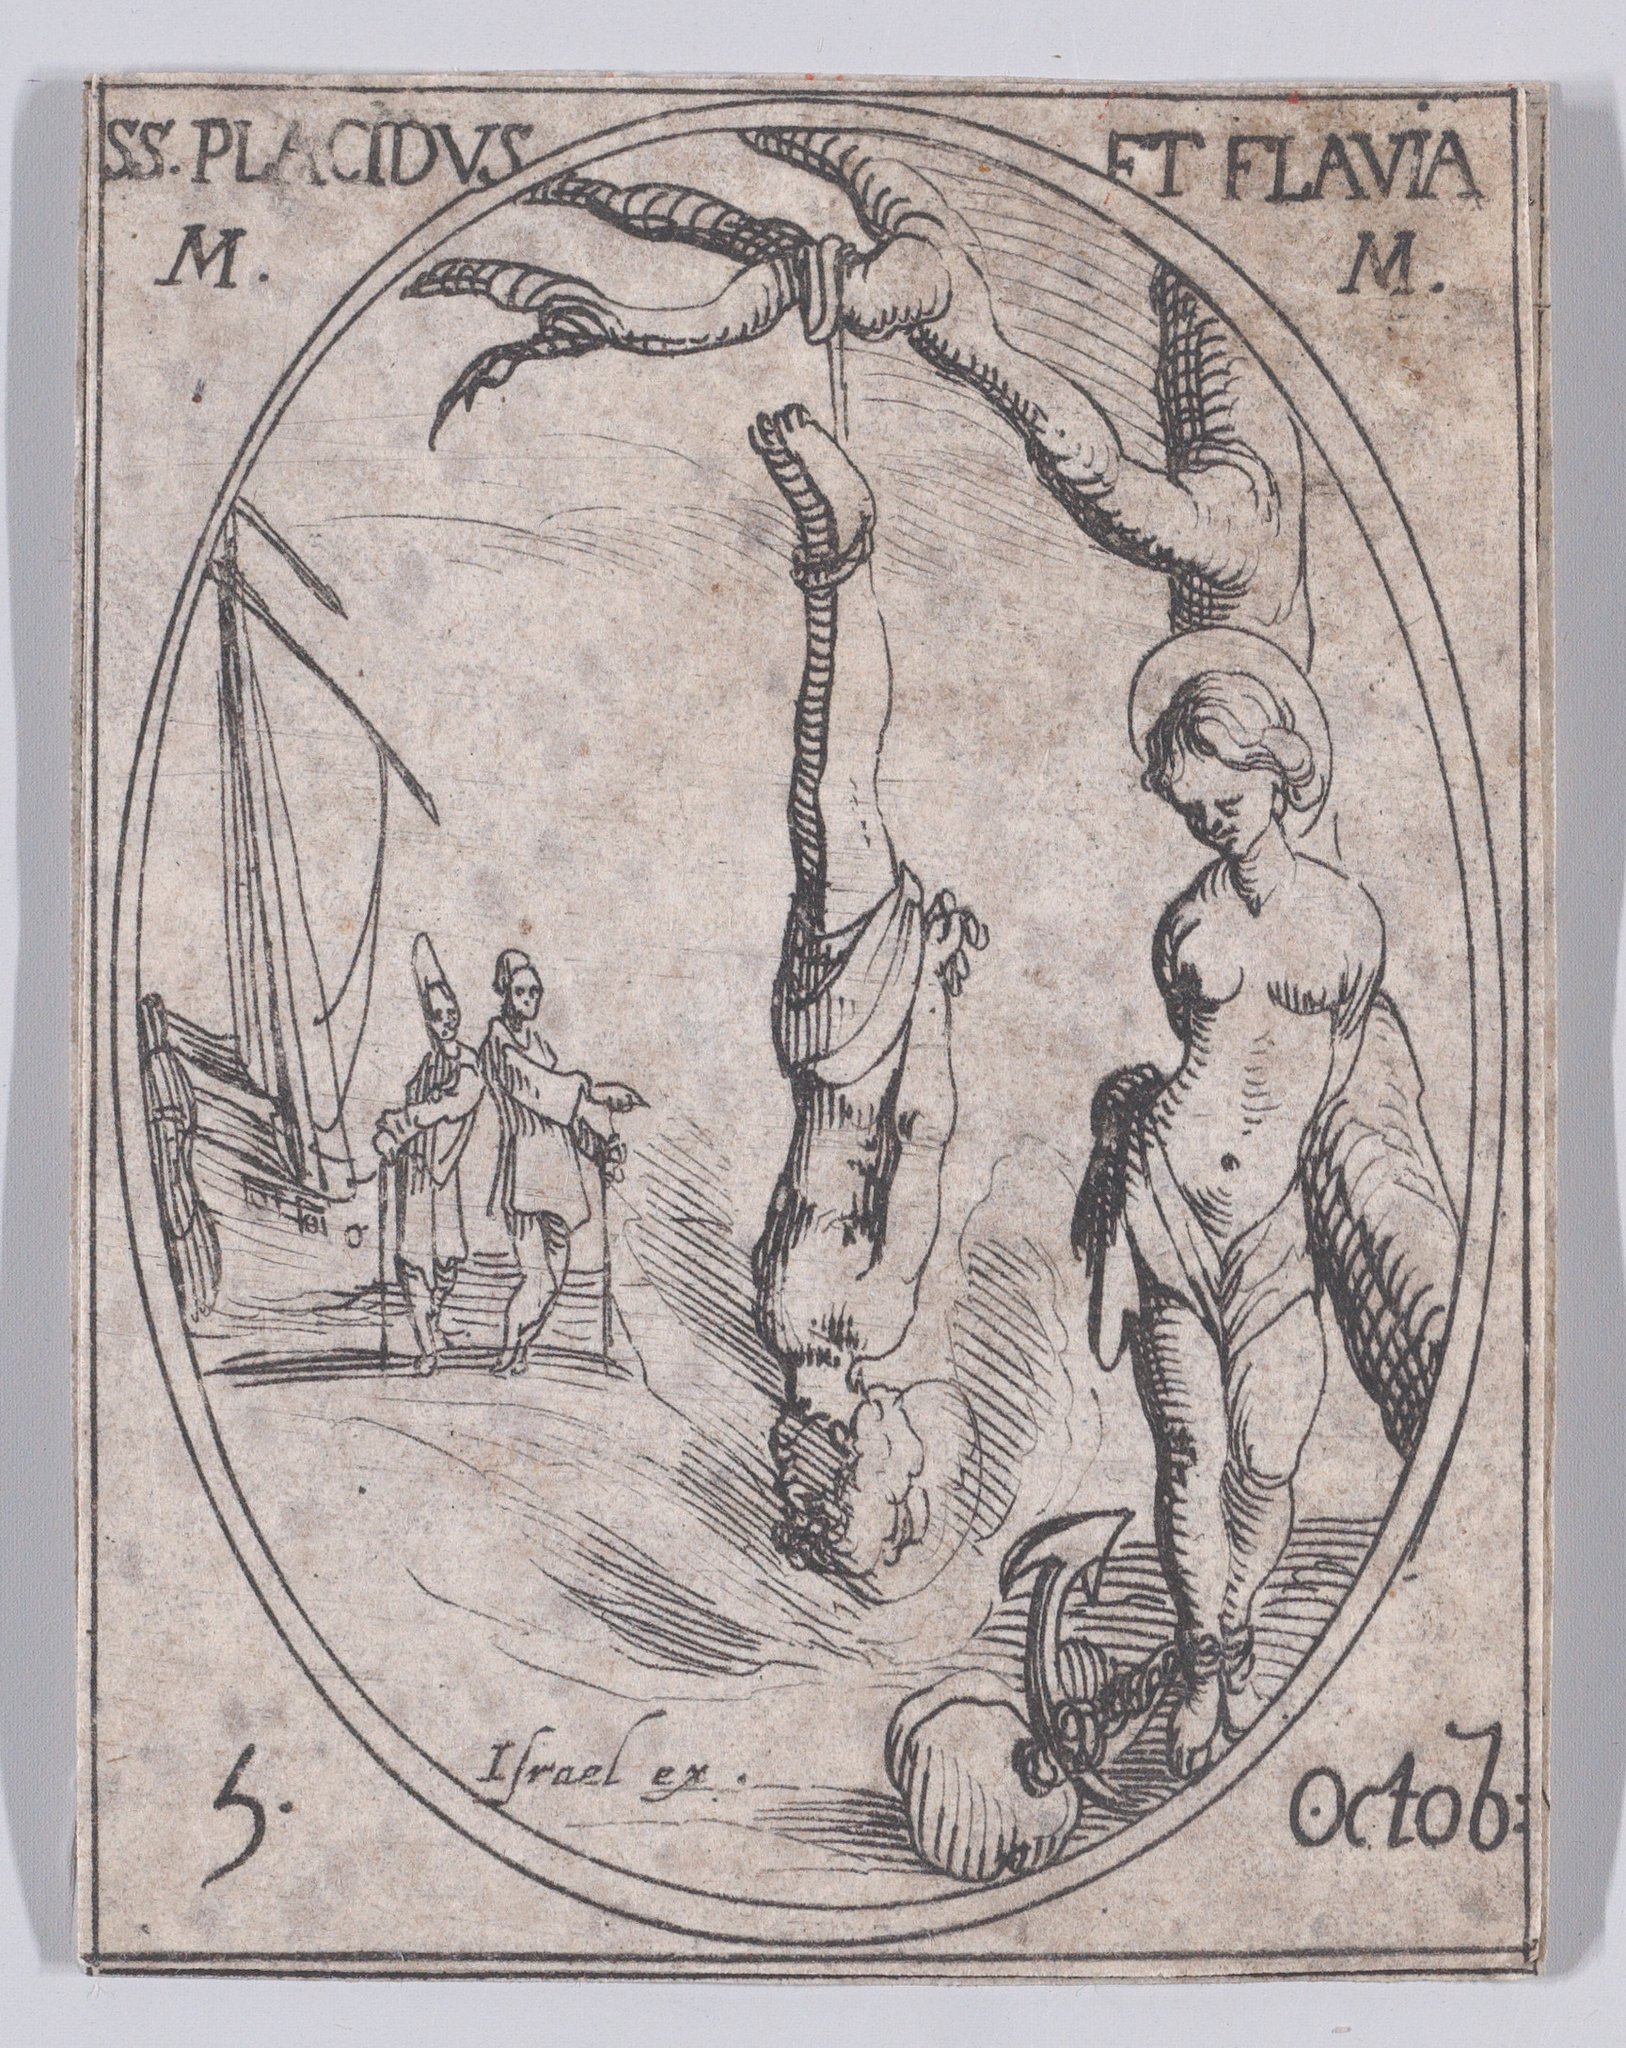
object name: print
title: Ste. Placide et Ste. Flavie, martyres (St. Placid and St. Flavia, Martyrs), October 5th, from "Les Images De Tous Les Saincts et Saintes de L'Année" (Images of All of the Saints and Religious Events of the Year)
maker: jacques callot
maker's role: artist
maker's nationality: french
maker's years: 1592-1635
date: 1636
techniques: etching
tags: men,women,saints